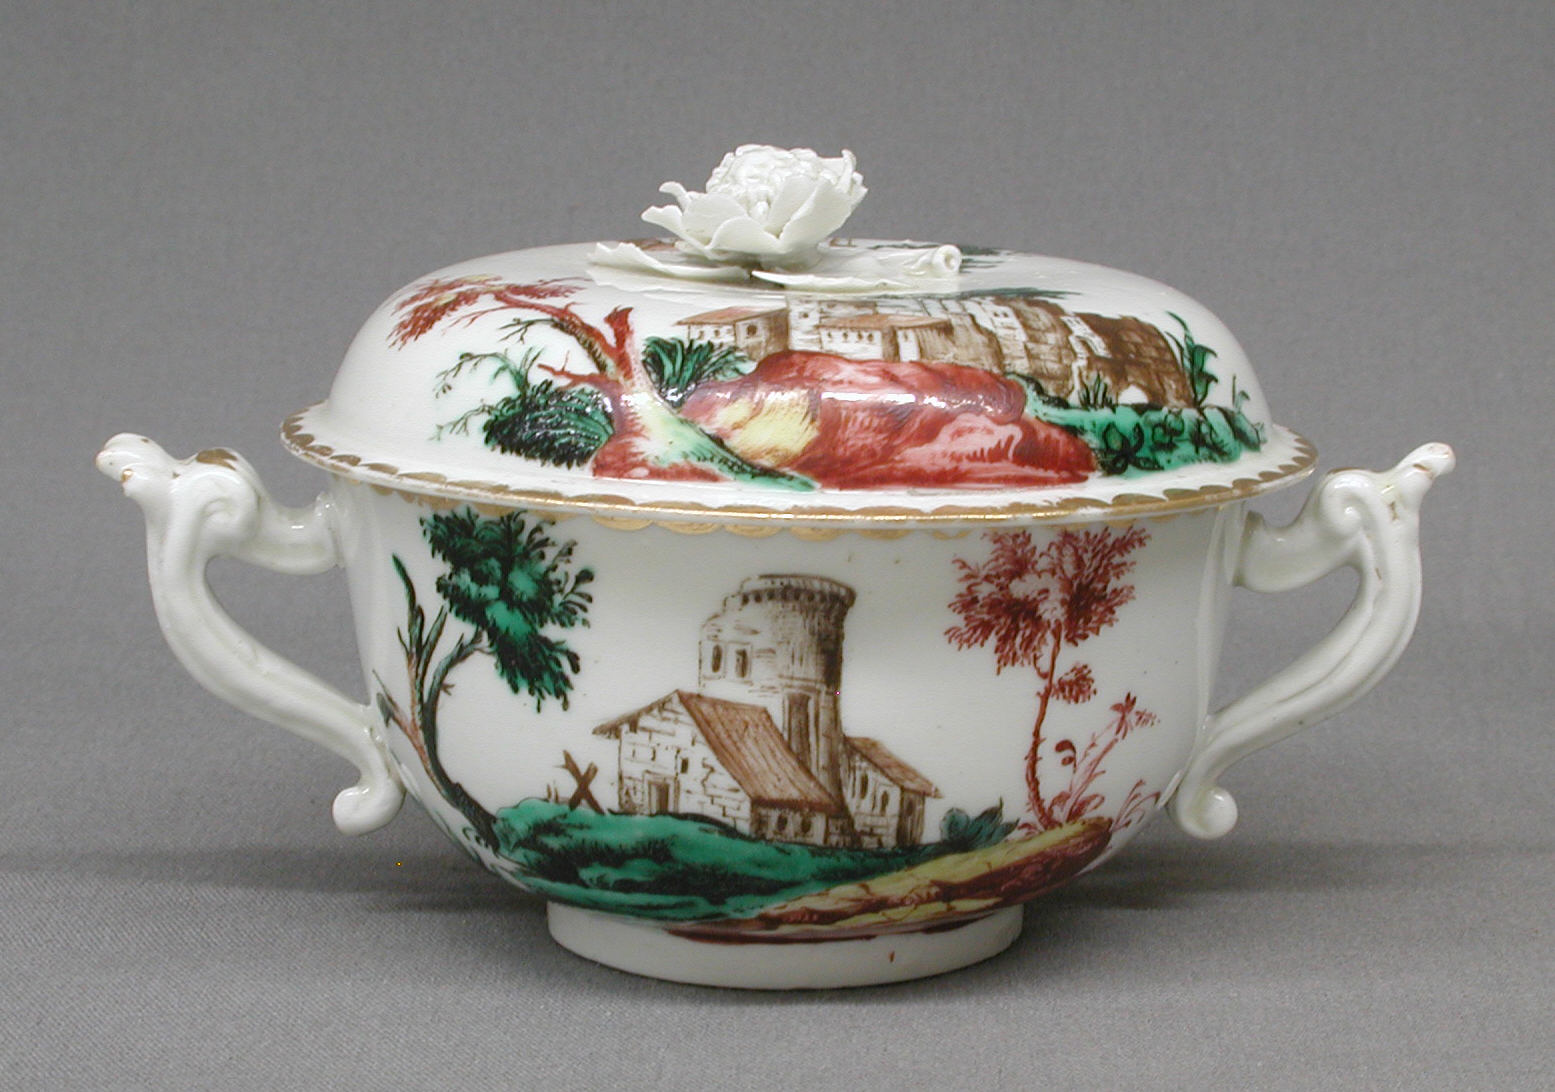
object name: bowl with cover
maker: le nove porcelain manufactory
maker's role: manufactory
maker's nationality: italian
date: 1765-1770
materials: soft paste porcelain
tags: houses,trees